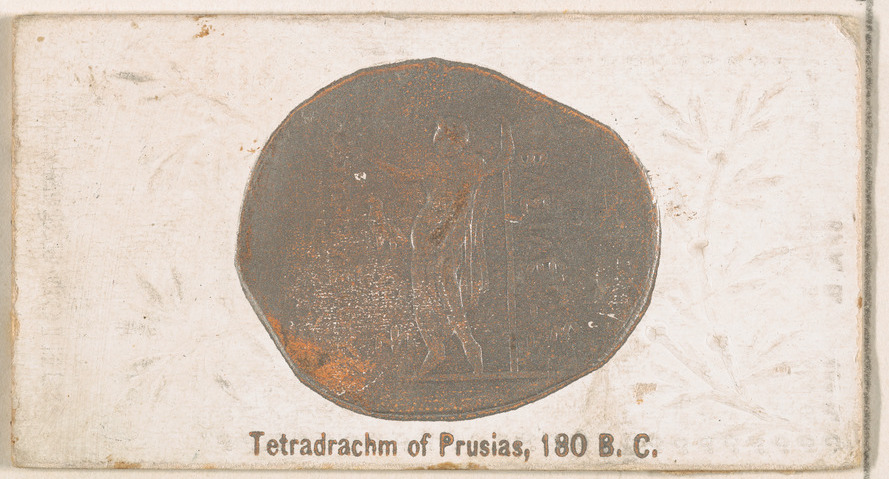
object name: print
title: Tetradrachm of Prusias, 180 B.C., from the Ancient Coins series (N180) issued by Wm. S. Kimball & Co.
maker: william s. kimball & company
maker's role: publisher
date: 1888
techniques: color lithograph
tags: coins